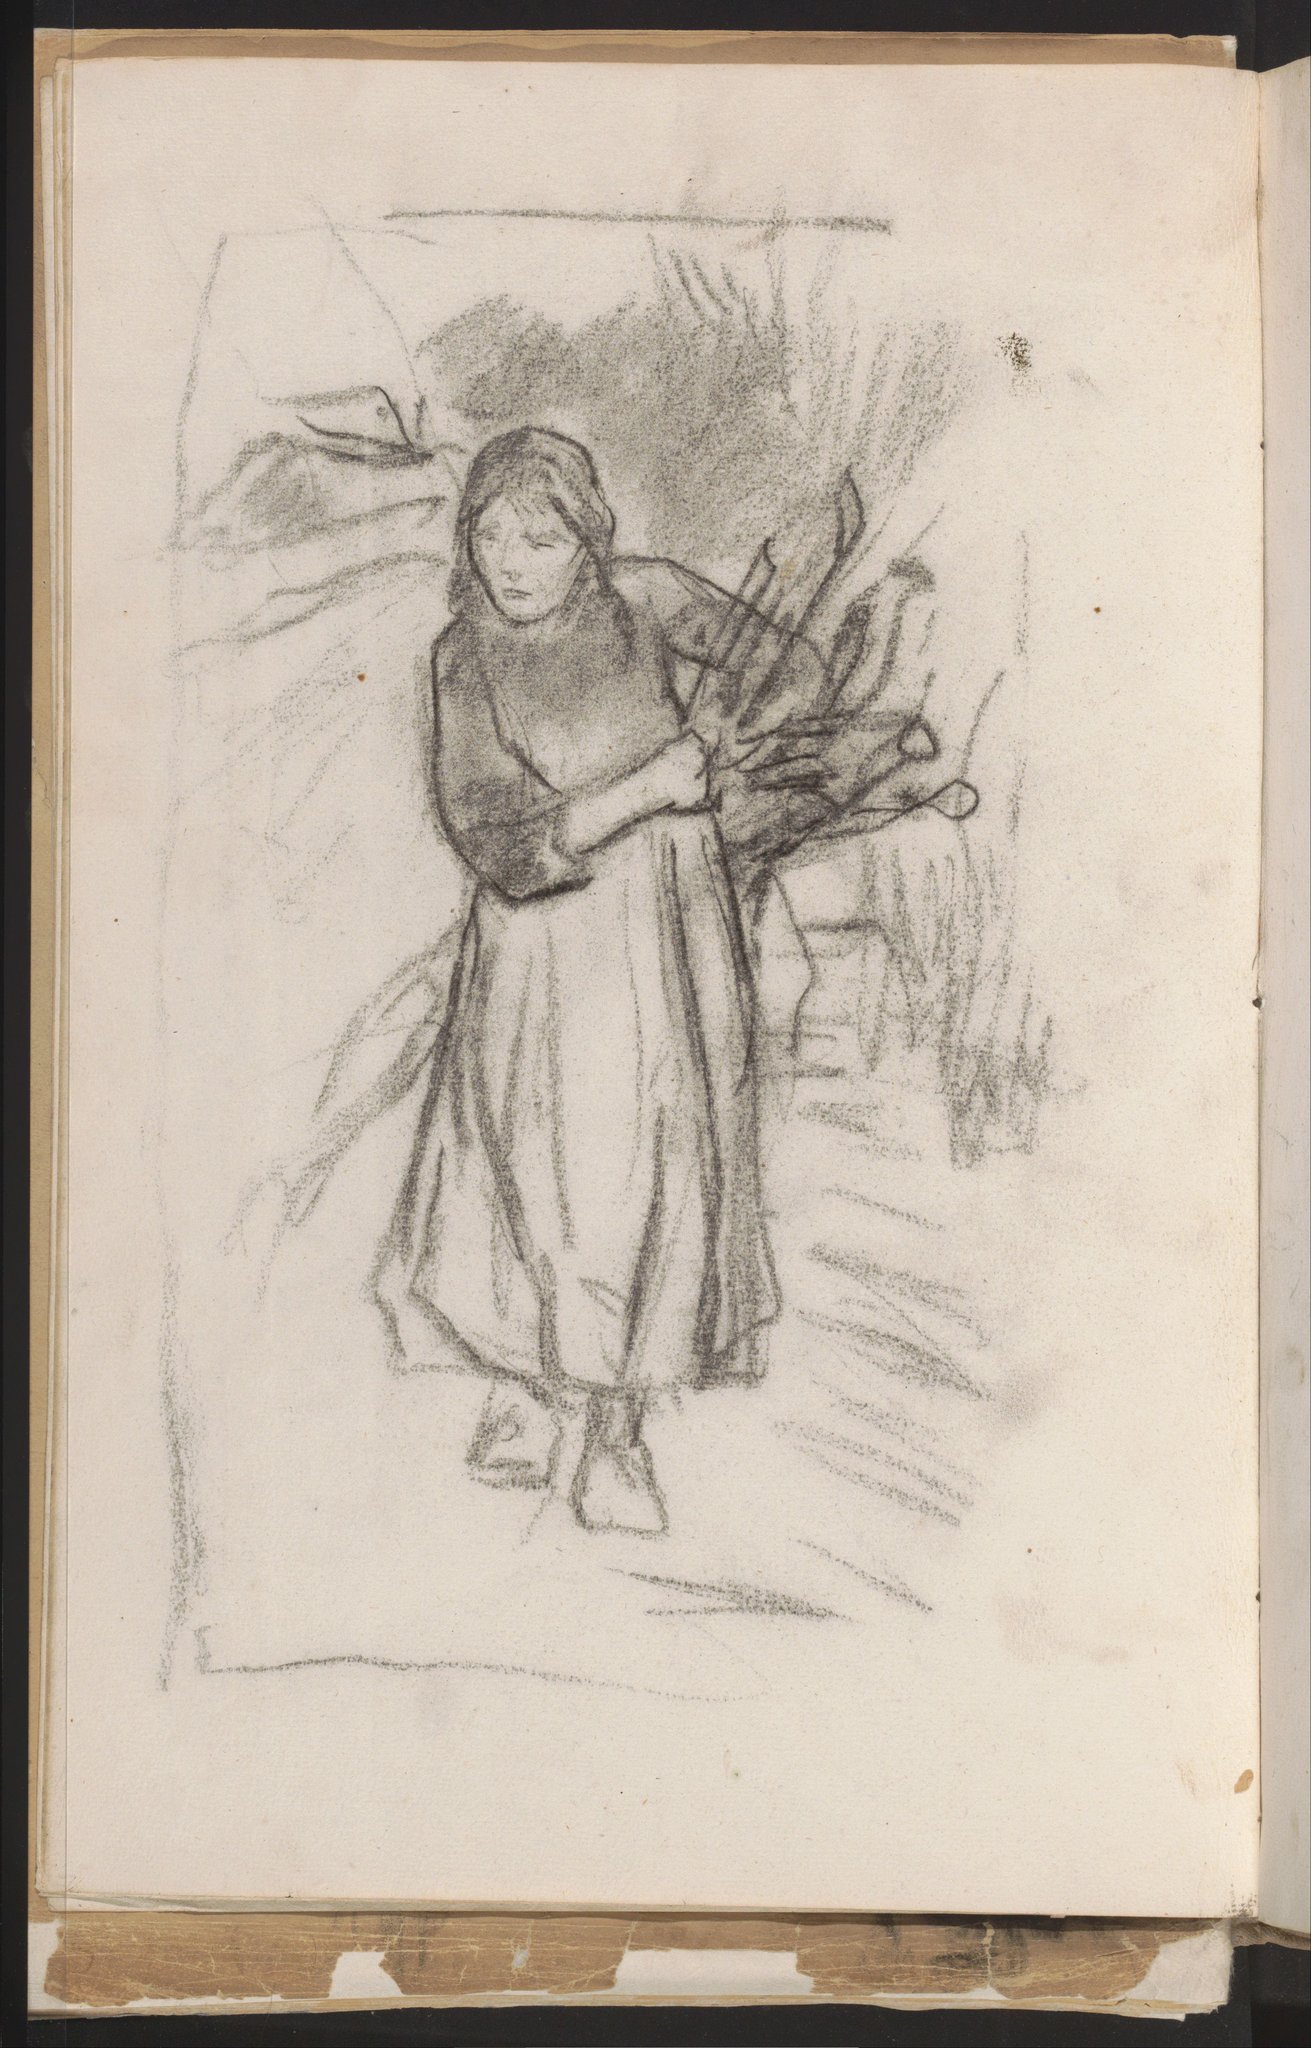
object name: sketchbook leaf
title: Jonge vrouw met sprokkelhout onder de arm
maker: albert neuhuys (1844-1914)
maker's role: draughtsman, painter, print maker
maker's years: 1844-1914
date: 1854-1914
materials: charcoal, paper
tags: industries ~ wood, adult woman, carrying something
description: Blad 19 verso uit een schetsboek met 53 bladen.